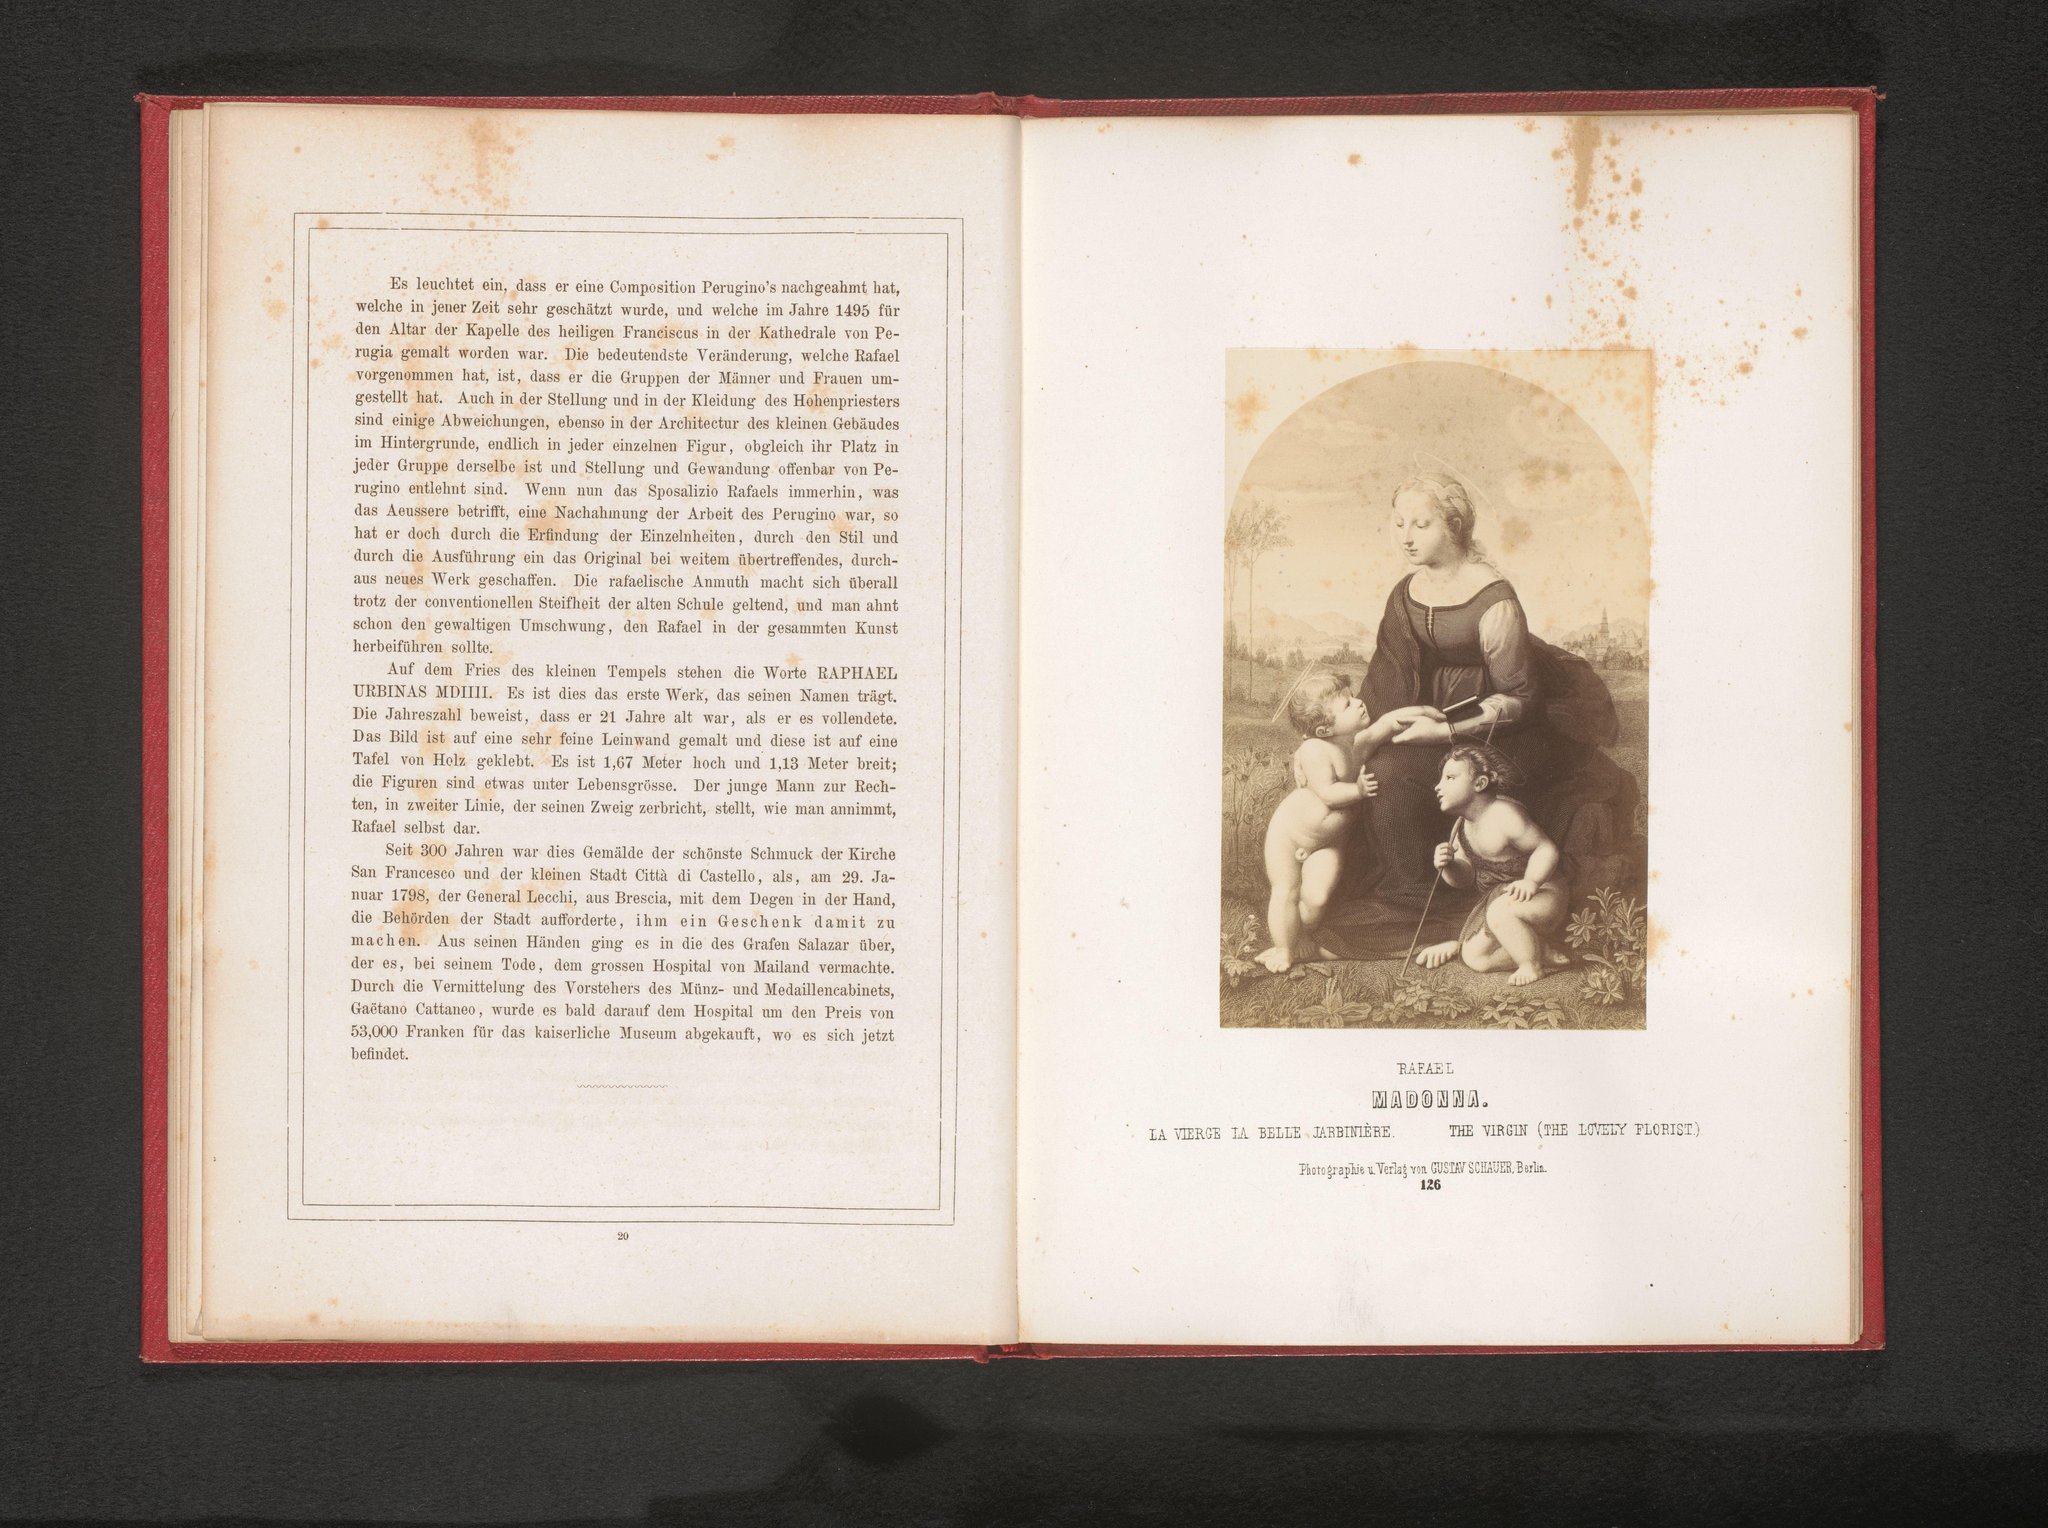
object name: page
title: Fotoreproductie van een prent naar een schilderij, voorstellende Maria met Kind en Johannes de Doper (La belle jardinière)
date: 1856-1861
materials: photographic support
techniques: albumen print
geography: berlin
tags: john the baptist as child ~ madonna-representations (n.b. secondary notation only)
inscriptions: number: ‘126’